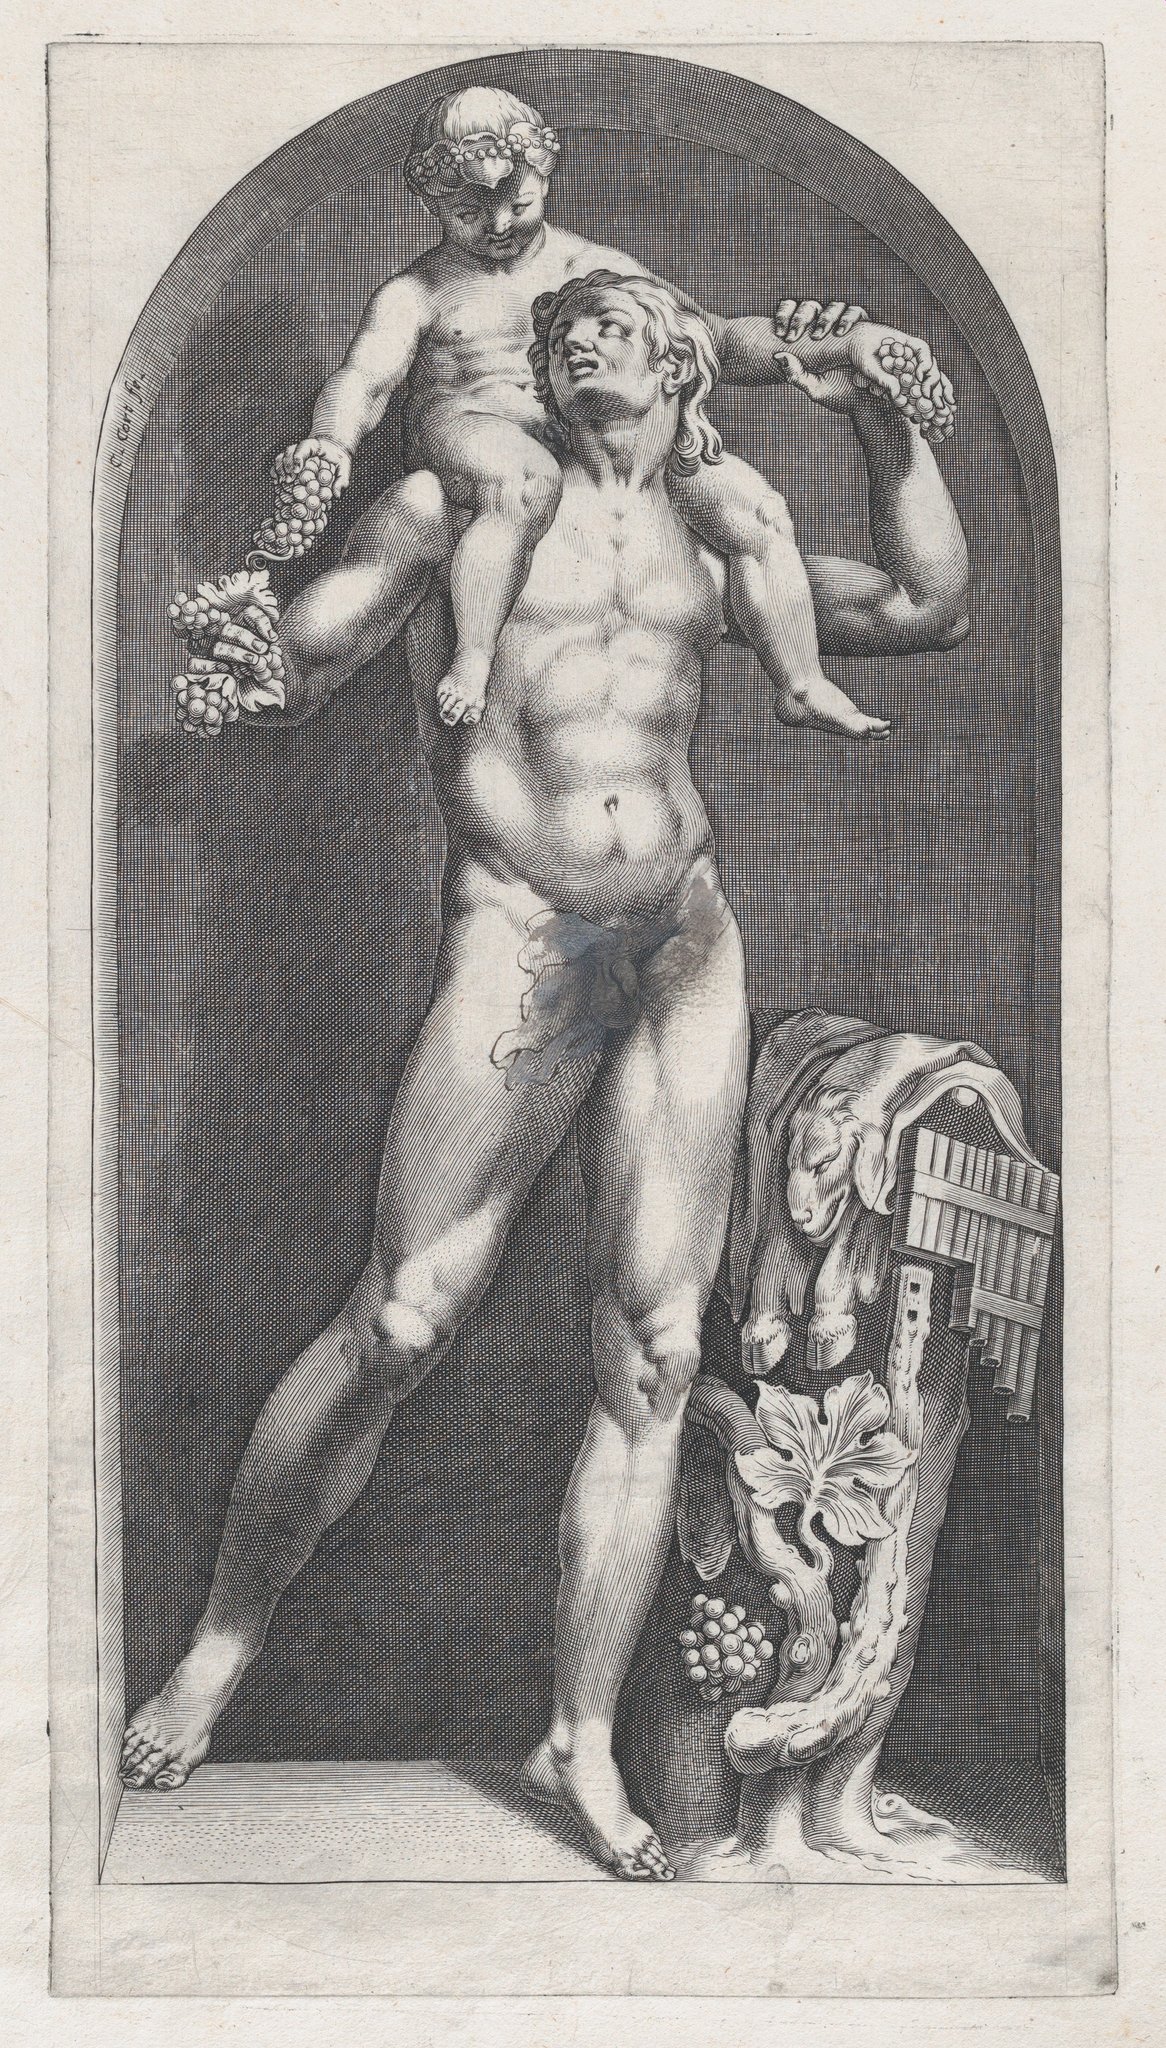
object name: print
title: Bacchus on the Shoulders of a Satyr, from "Speculum Romanae Magnificentiae"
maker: cornelis cort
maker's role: artist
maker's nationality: netherlandish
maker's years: 1533-1578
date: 1501-1600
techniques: engraving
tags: musical instruments,fruit,bacchus,satyrs